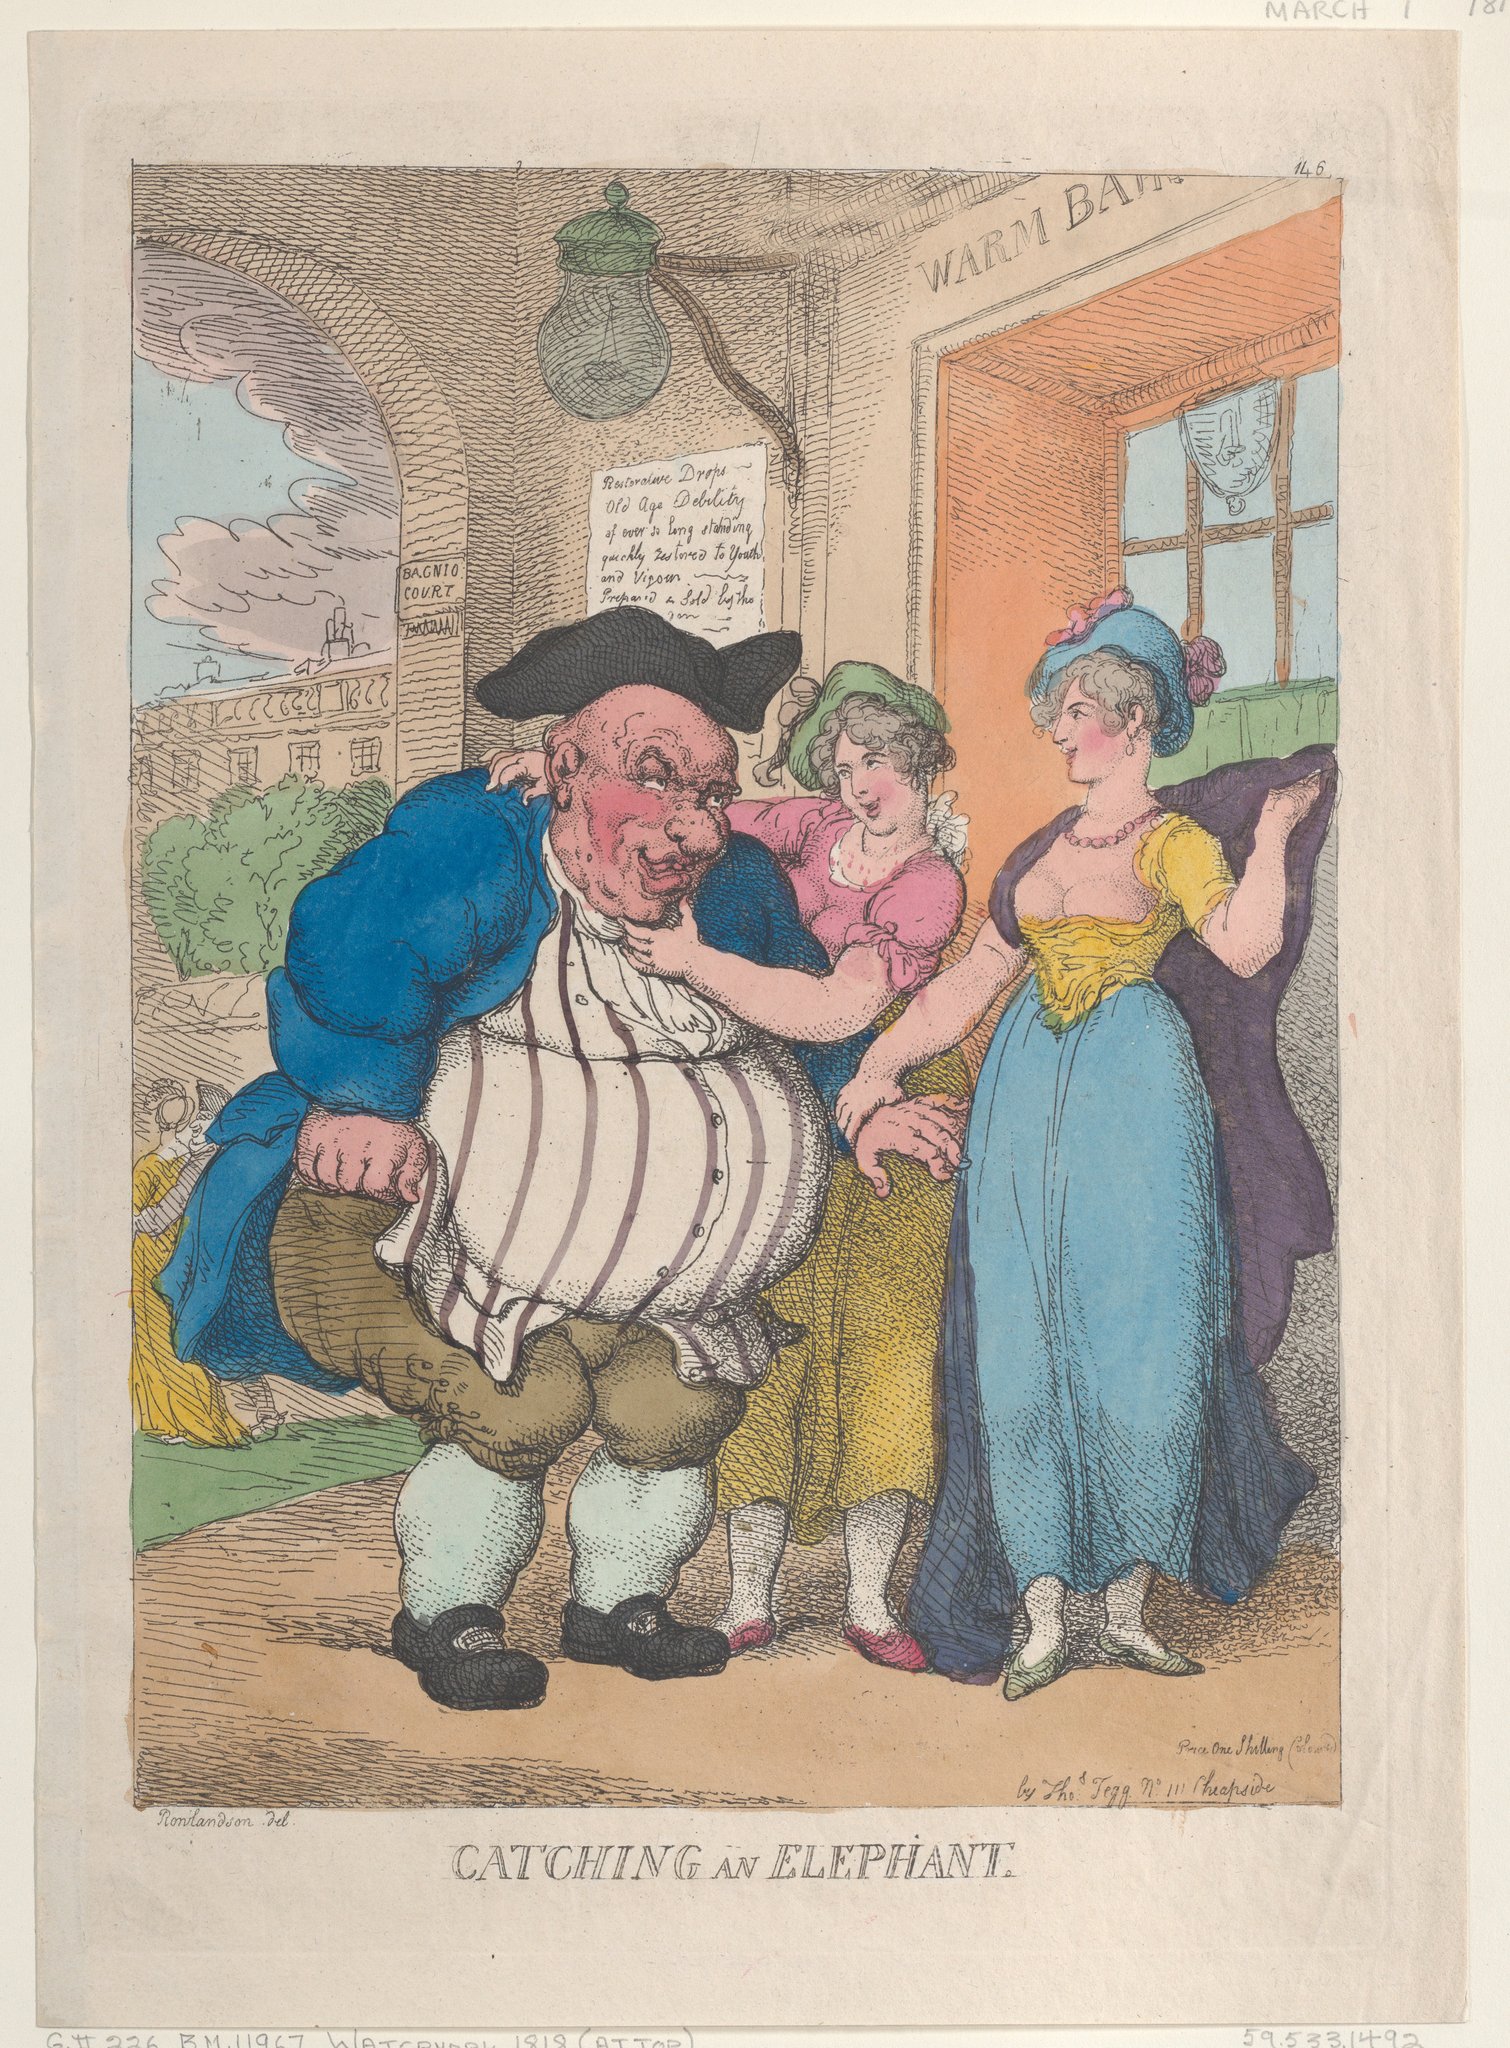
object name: print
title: Catching an Elephant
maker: thomas rowlandson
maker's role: artist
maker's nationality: british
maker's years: 1757-1827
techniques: etching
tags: satire,men,women